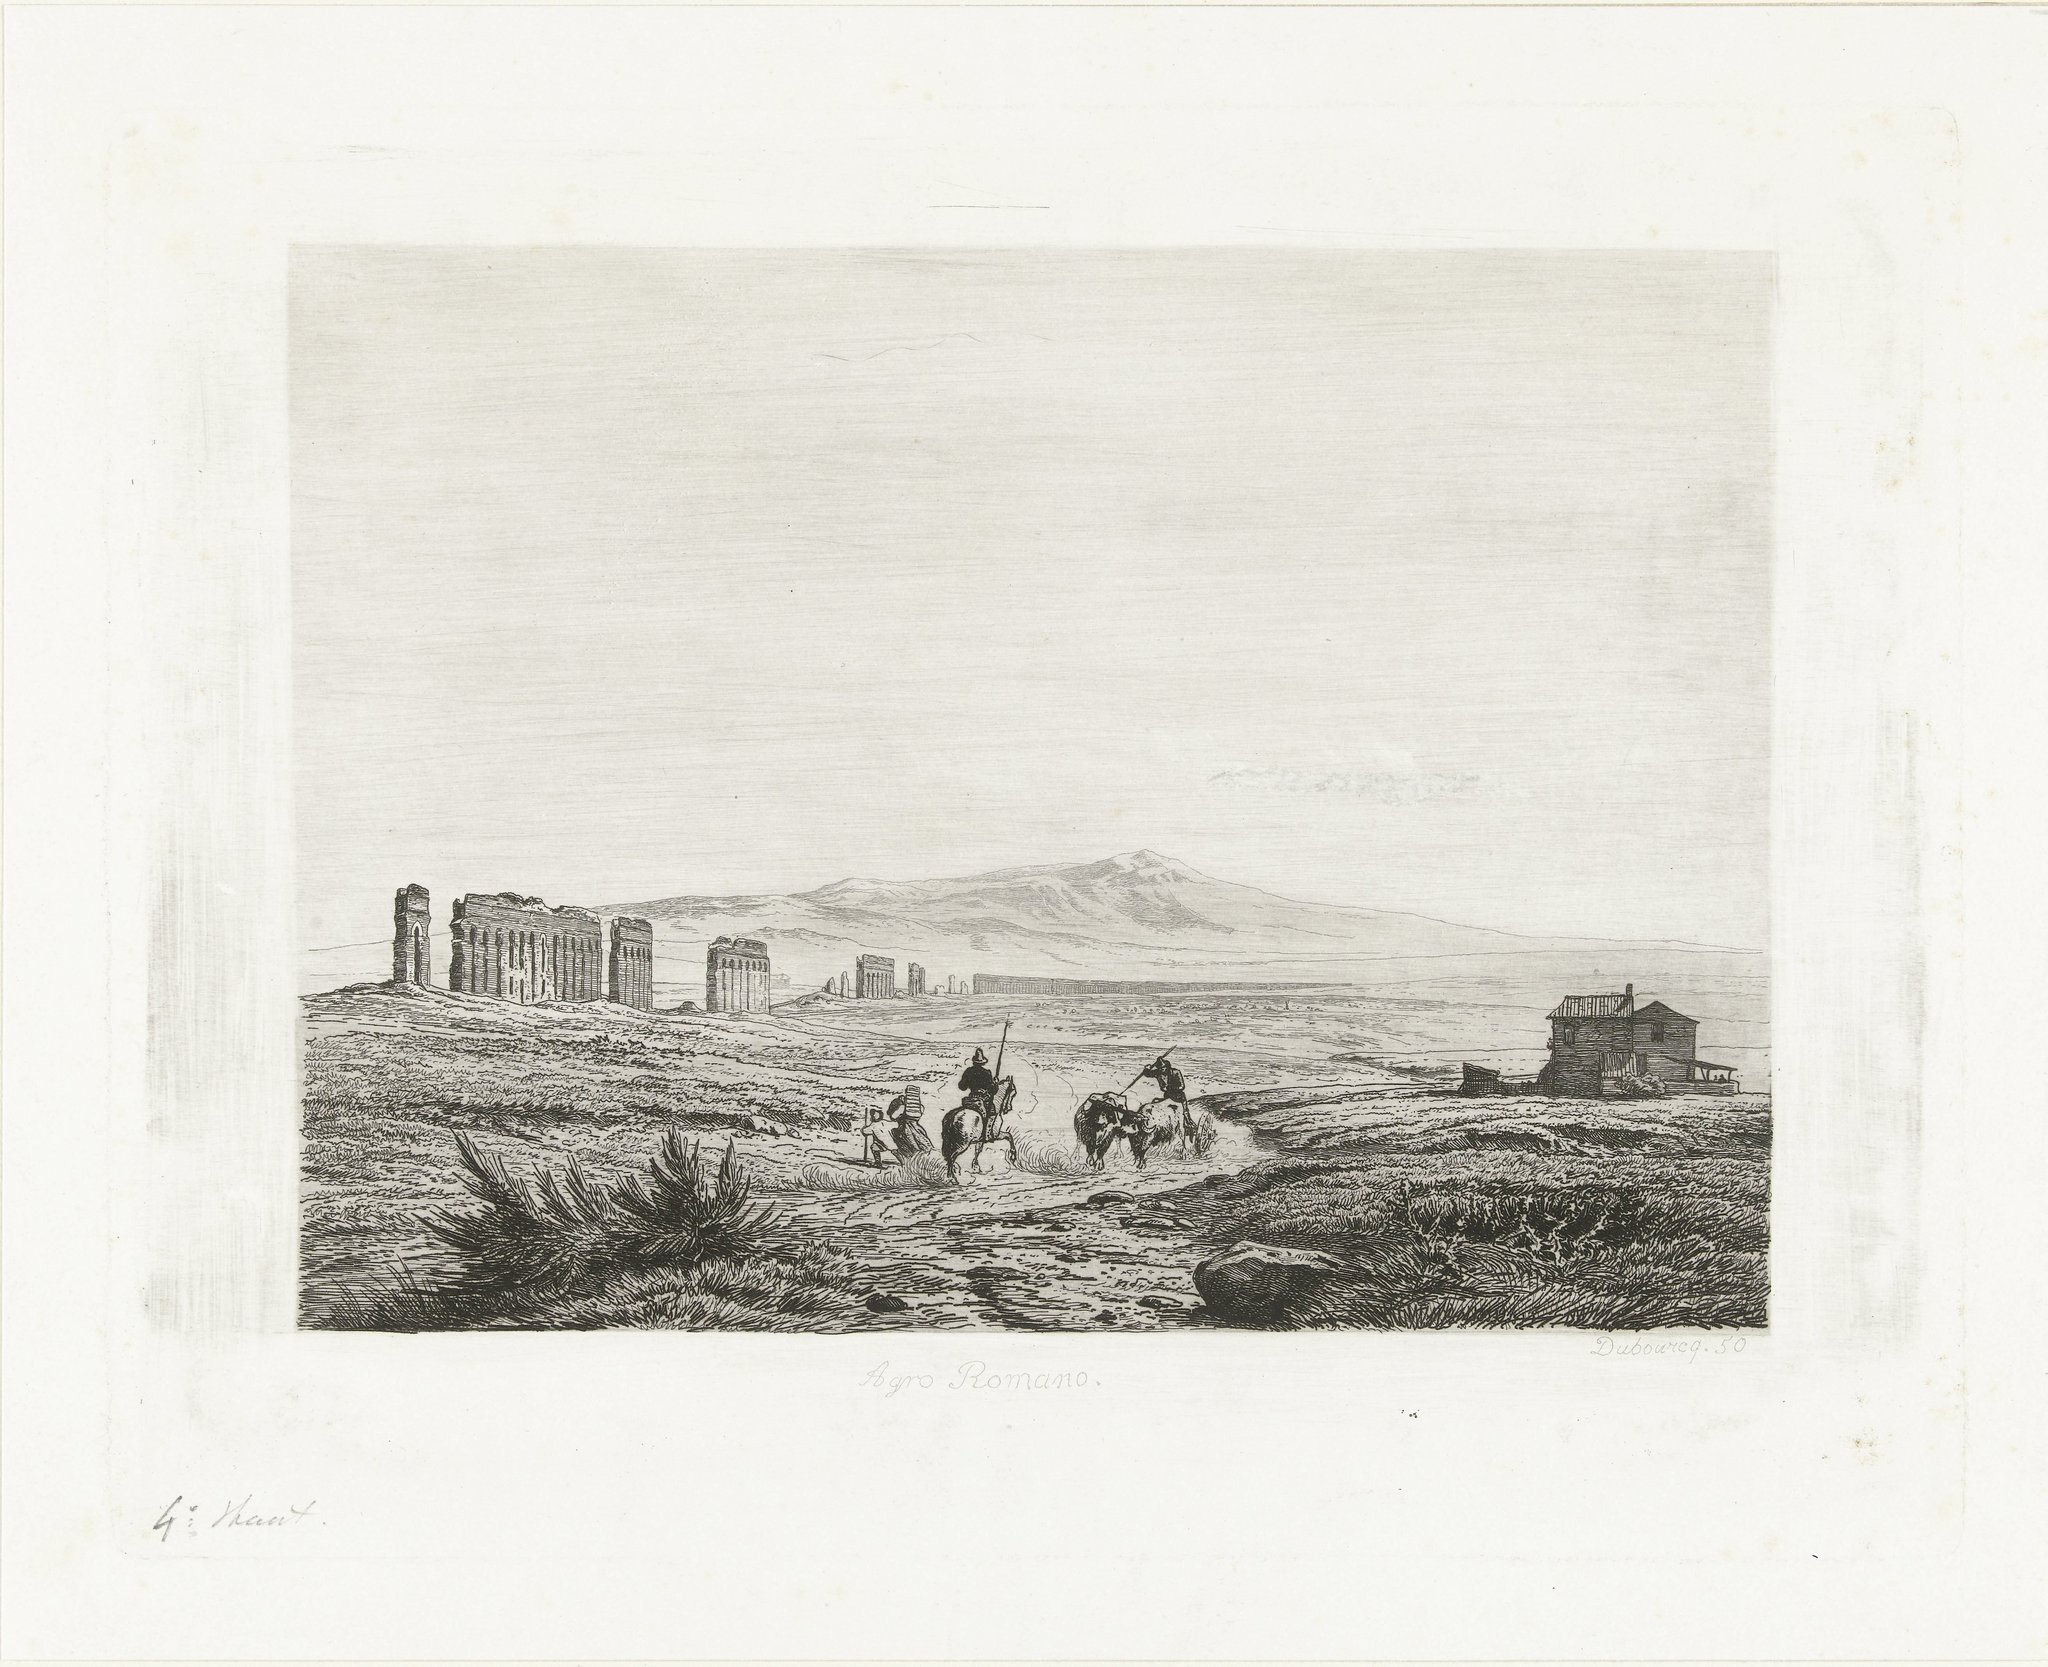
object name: print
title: Zes etsproeven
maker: pierre louis dubourcq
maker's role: draughtsman, painter, print maker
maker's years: 1815-1873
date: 1850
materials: paper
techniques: etching, intaglio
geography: netherlands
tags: landscape with ruins, rome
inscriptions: collector's mark: Lugt 2228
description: Een ruiter en een boer met een ossenkar in de open vlakte bij overblijfselen van een Romeins aquaduct. Rechts een huis.